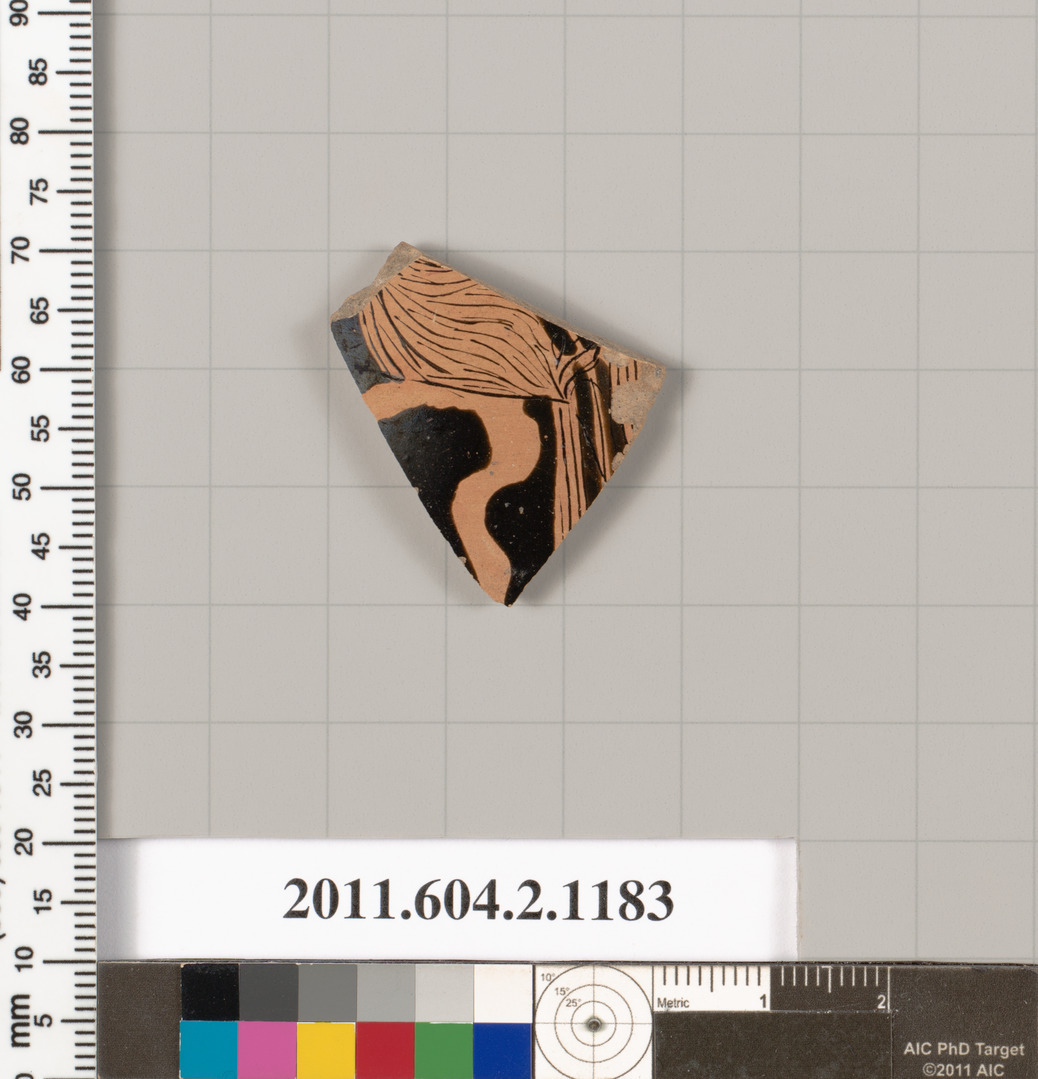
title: Terracotta fragment of a small, closed shape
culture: greek, attic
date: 460-440 BCE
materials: terracotta